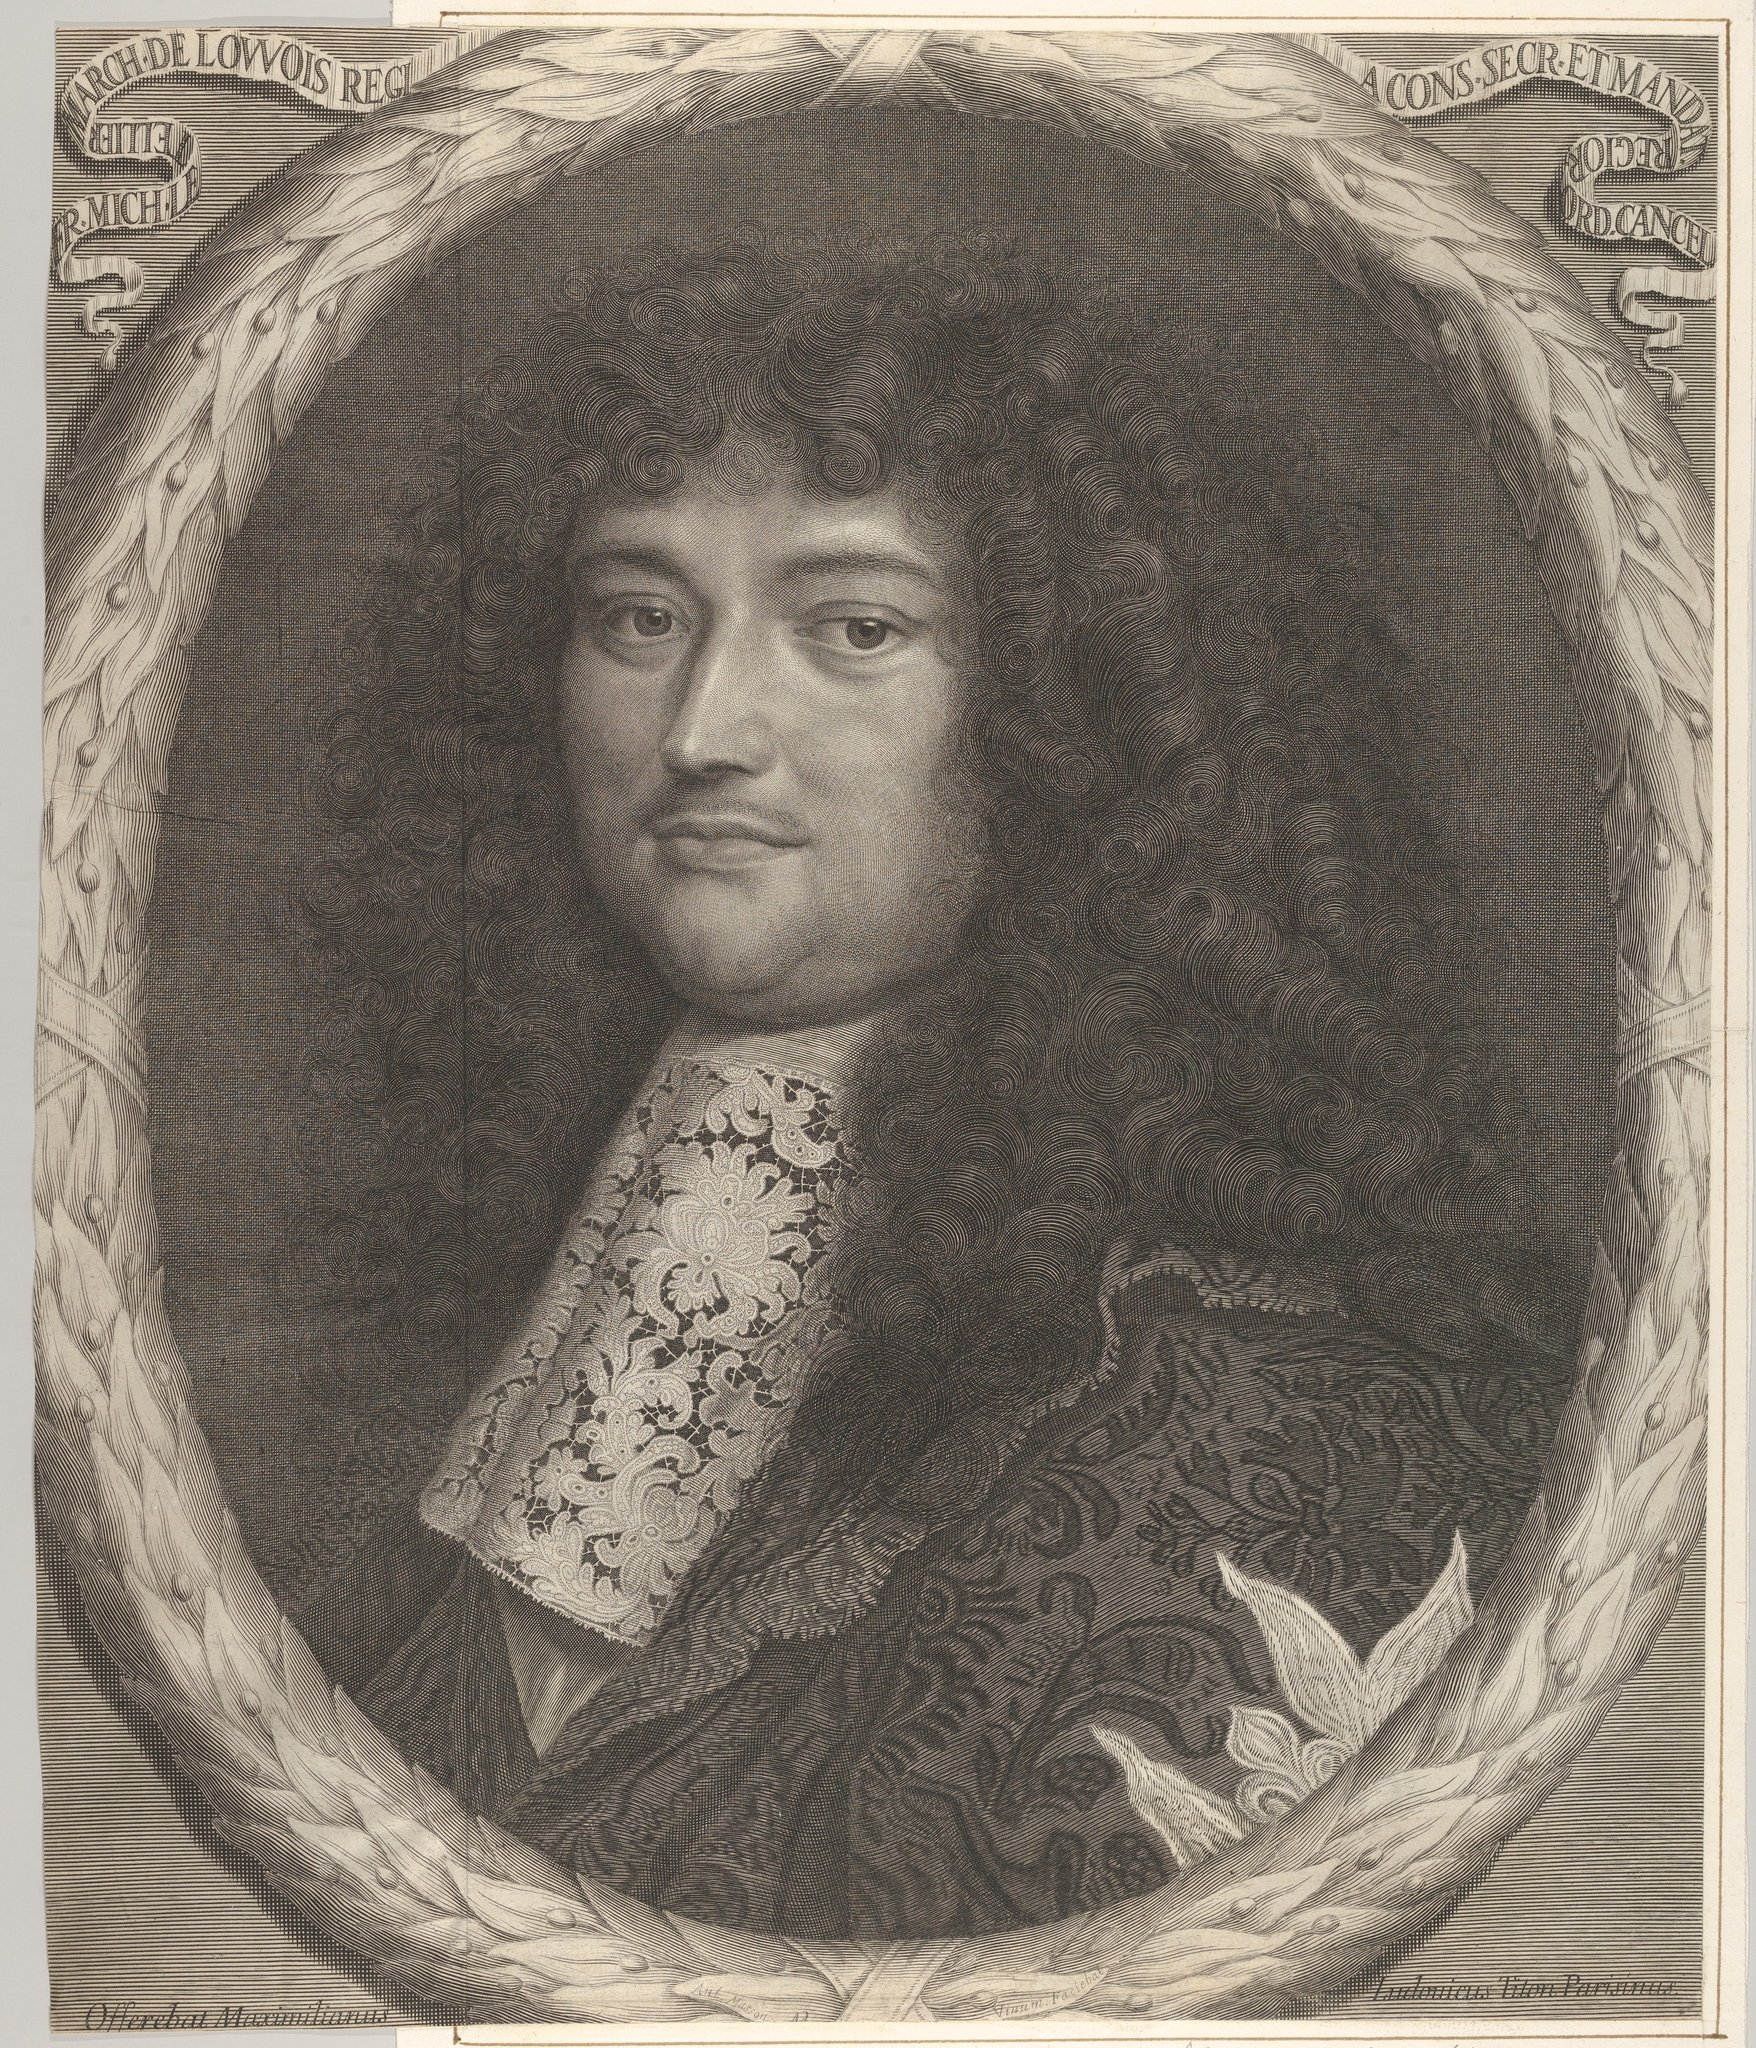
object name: print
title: François-Michel Le Tellier, marquis de Louvois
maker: antoine masson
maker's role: artist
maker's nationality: french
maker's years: 1636-1700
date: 1601-1700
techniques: engraving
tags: men,portraits